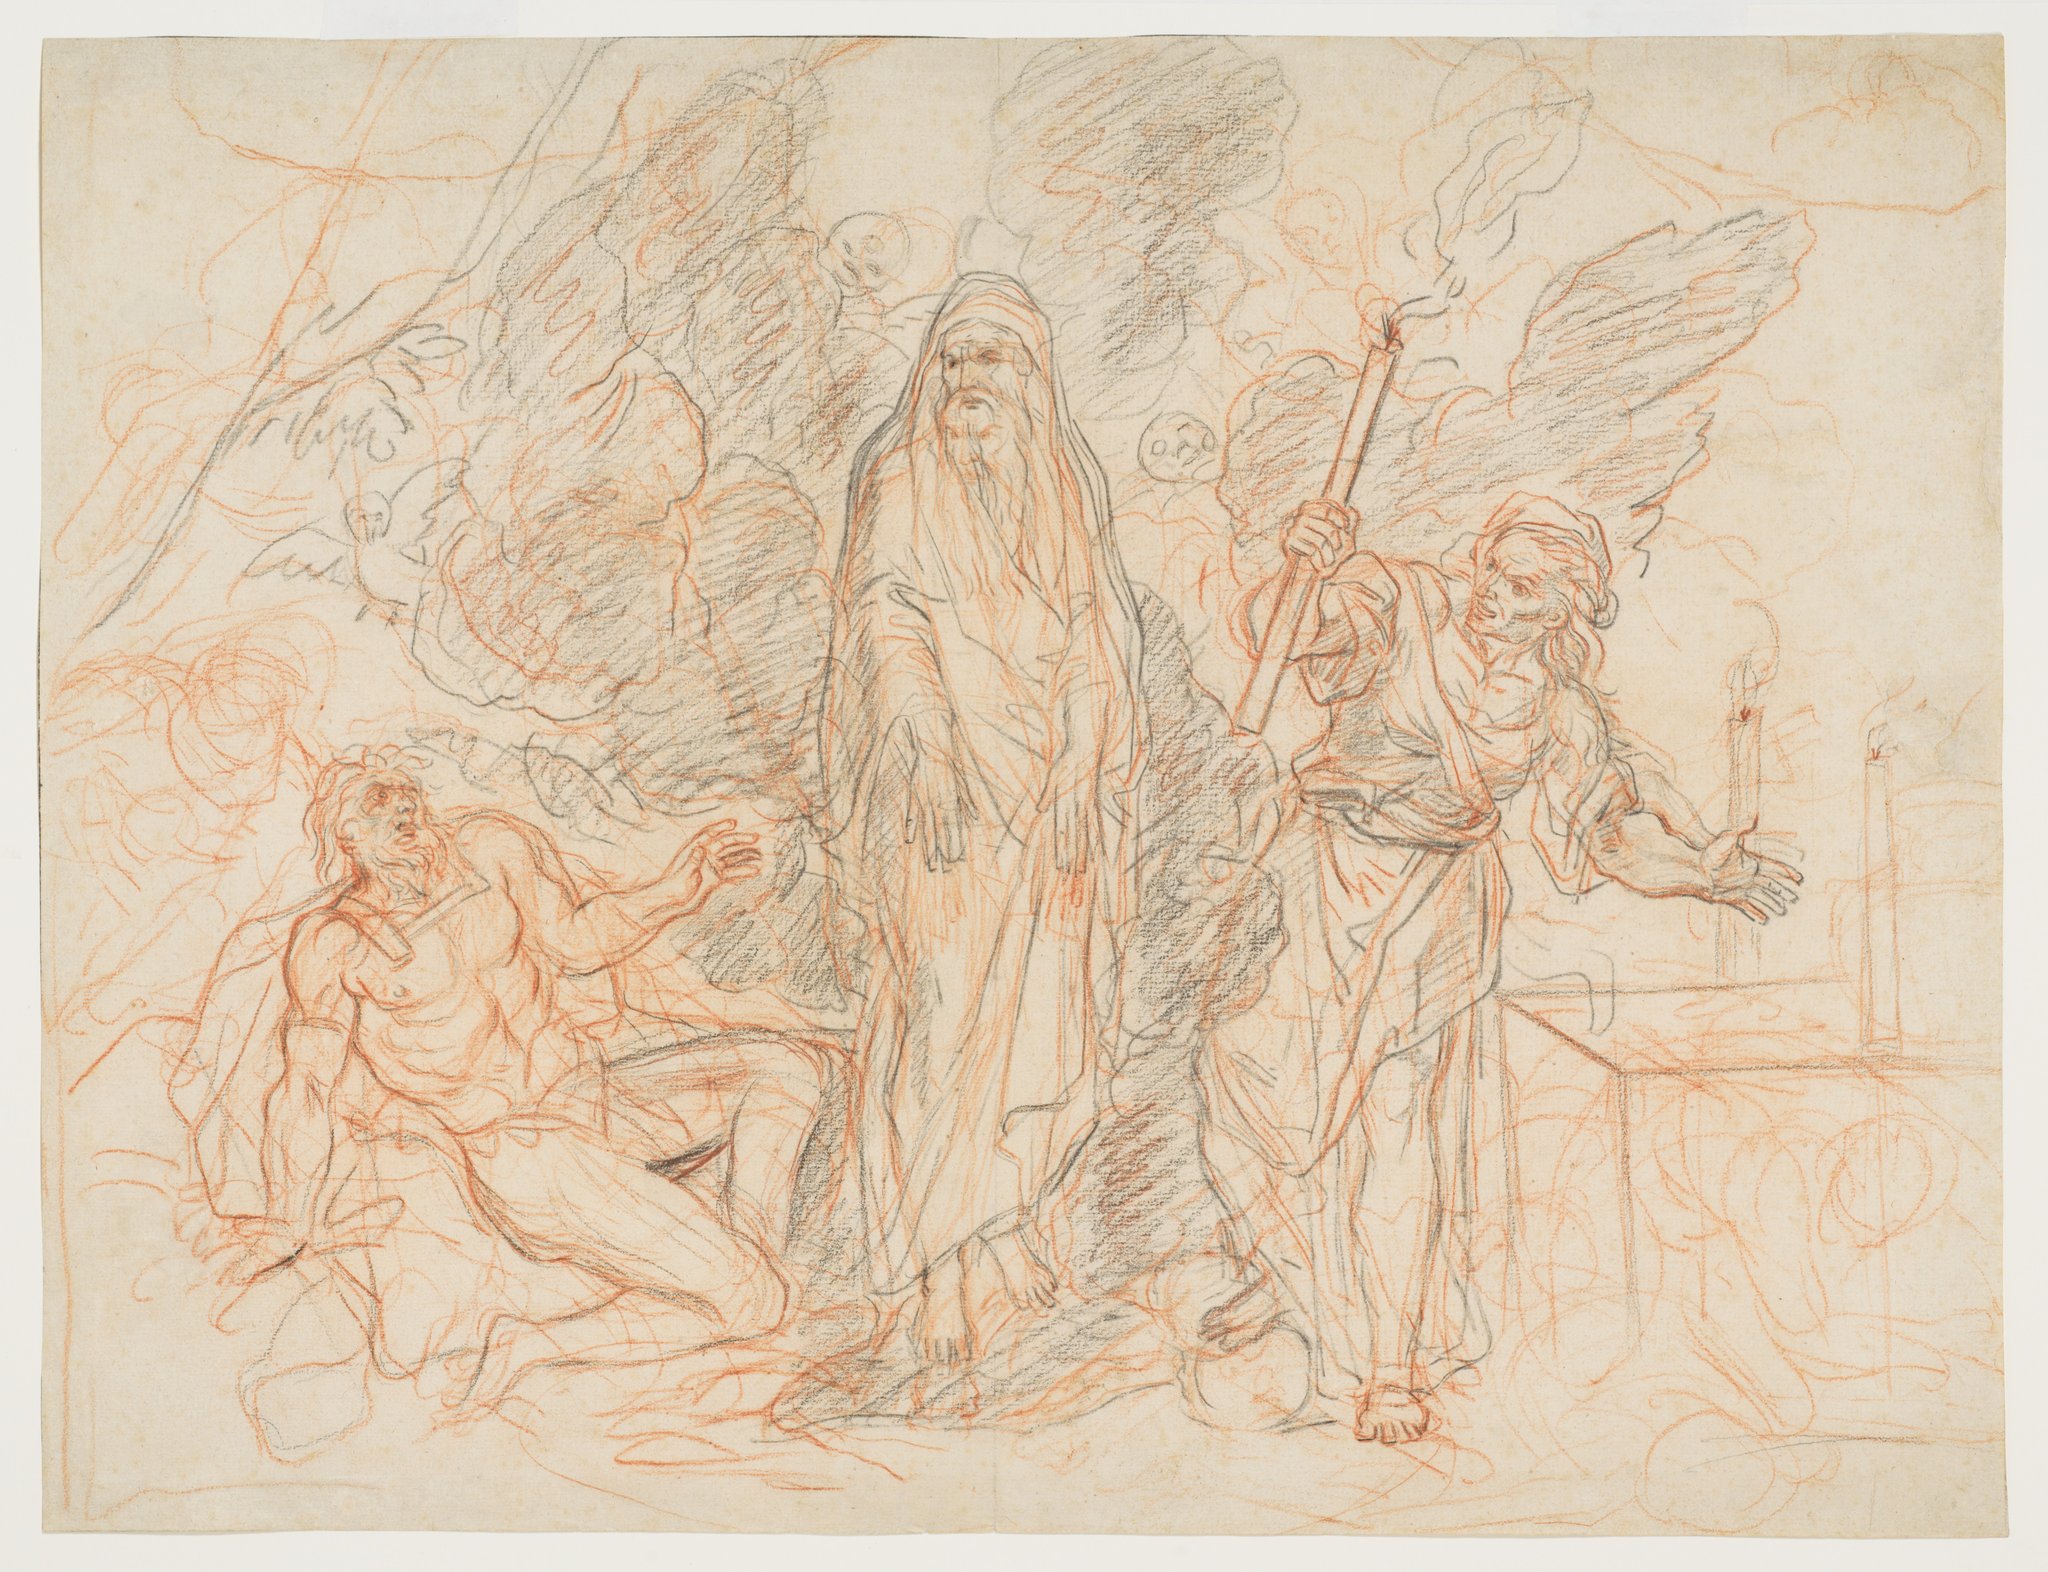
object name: drawing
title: The Shade of the Prophet Samuel Invoked by King Saul and Conjured by the Witch of Endor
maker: antoine coypel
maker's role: artist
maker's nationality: french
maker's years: 1661-1722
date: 1695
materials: chalk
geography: france